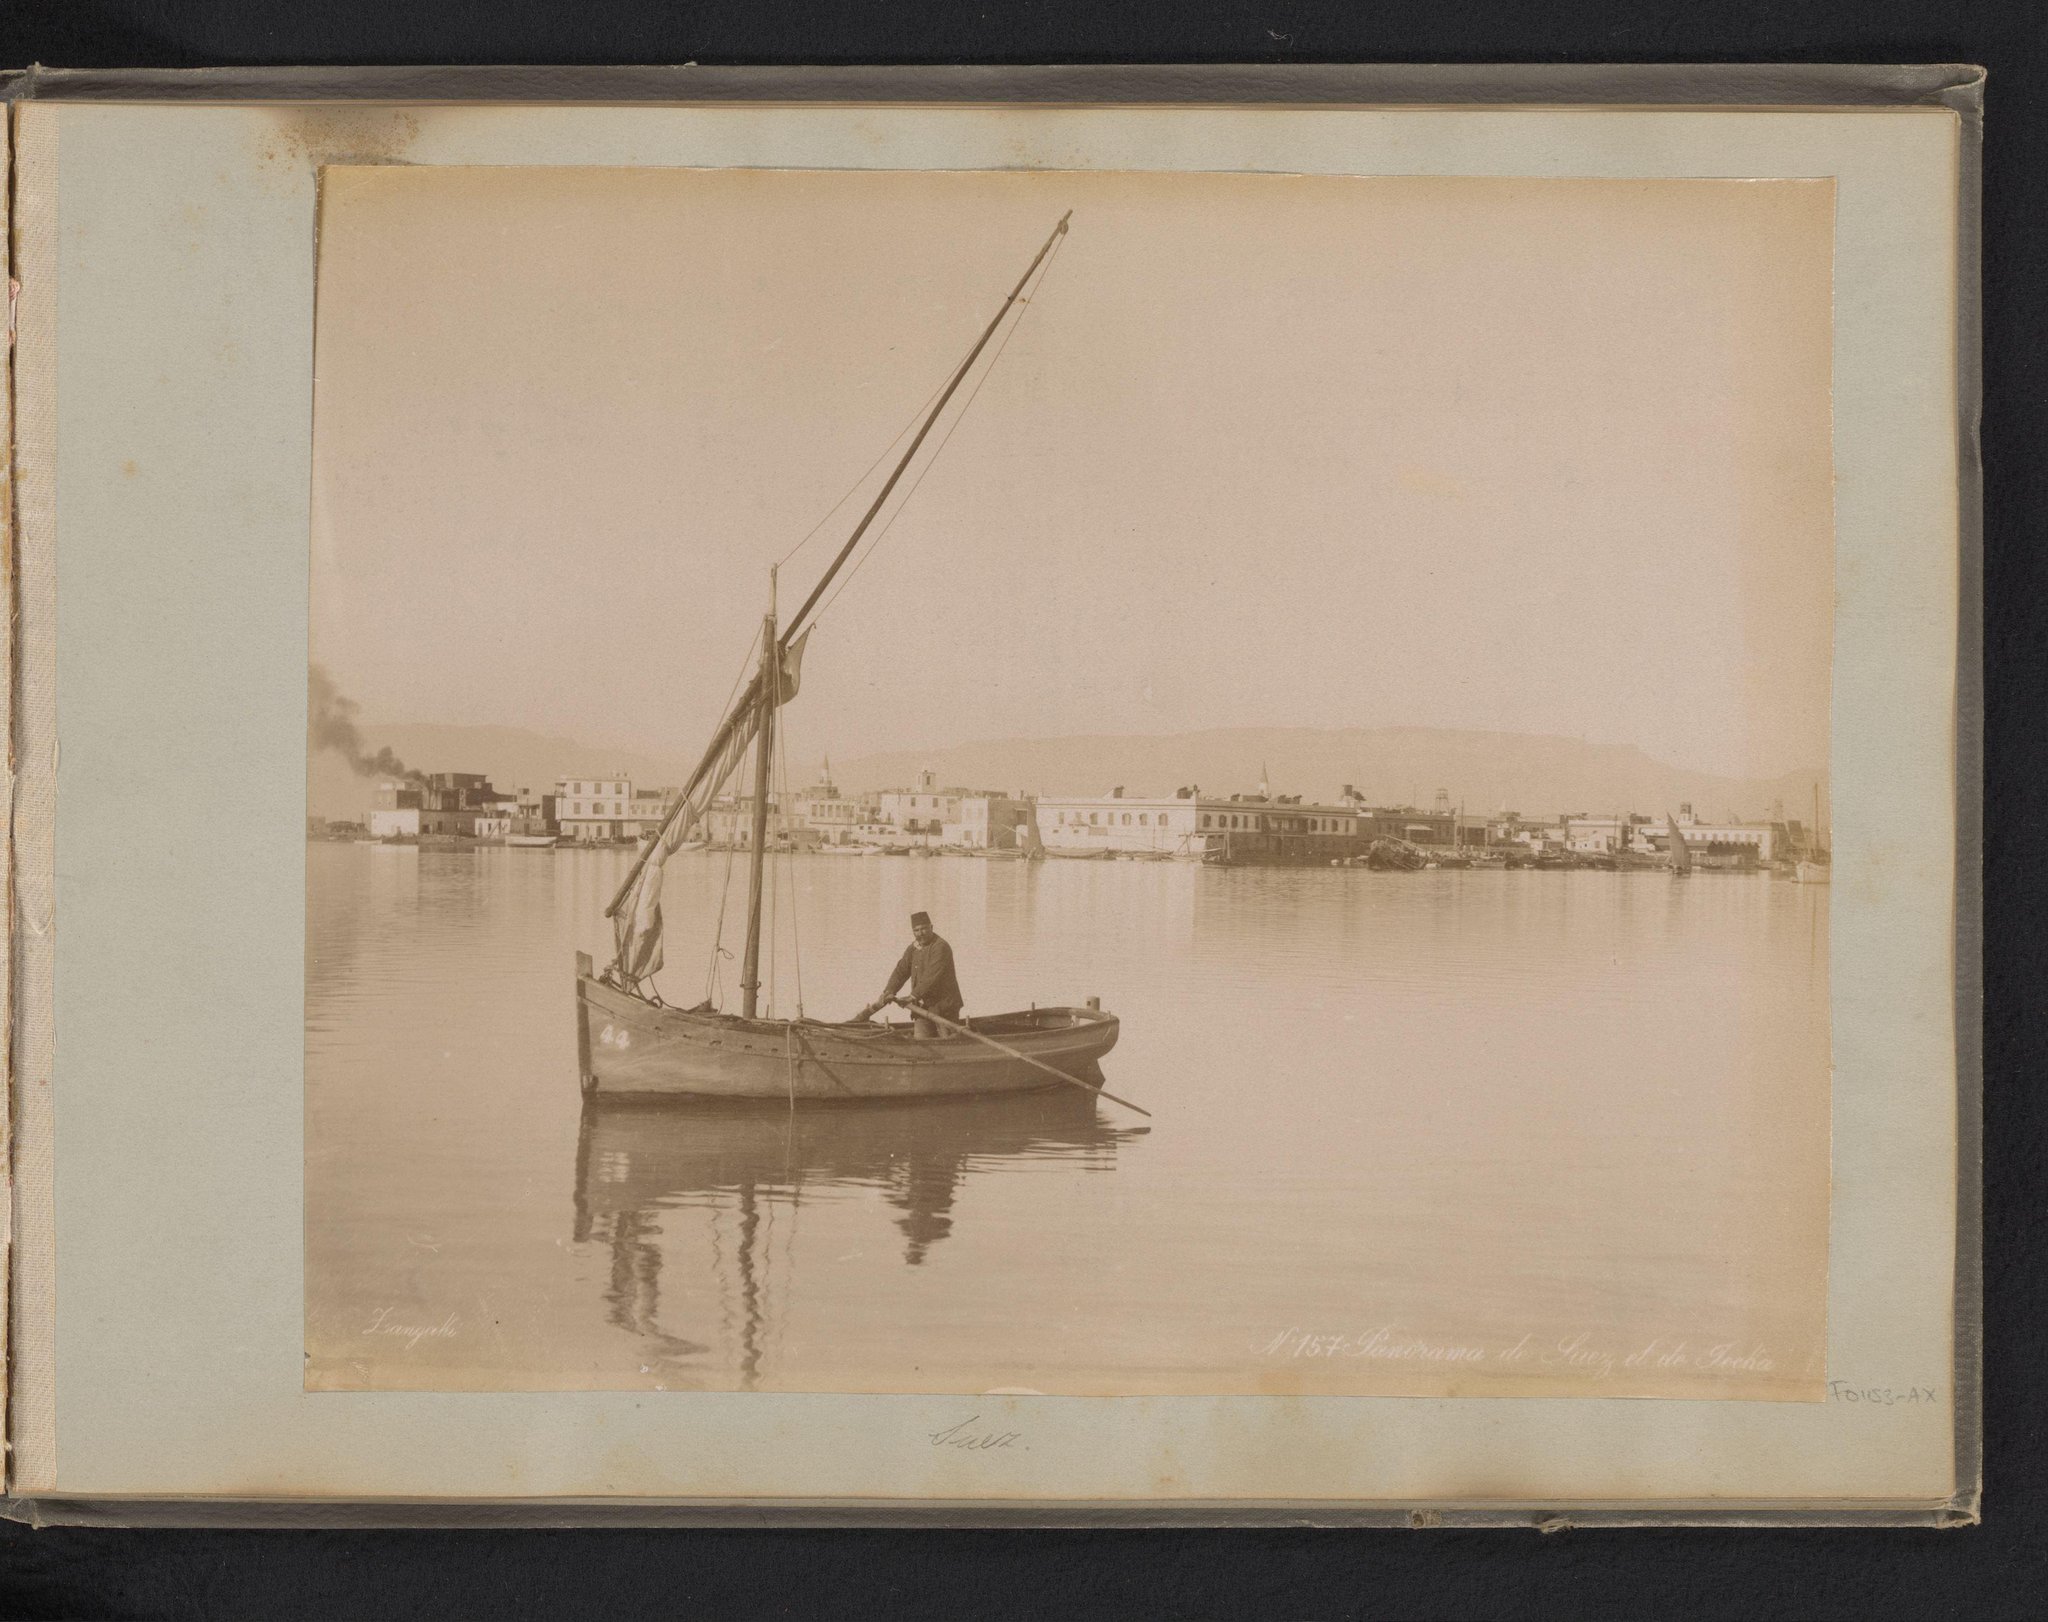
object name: photograph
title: Suez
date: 1885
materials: photographic support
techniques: albumen print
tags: sailing-ship, sailing-boat, rowing-boat, canoe, etc.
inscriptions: inscription: ‘No. 157 Panorama de Suez et de Focka’